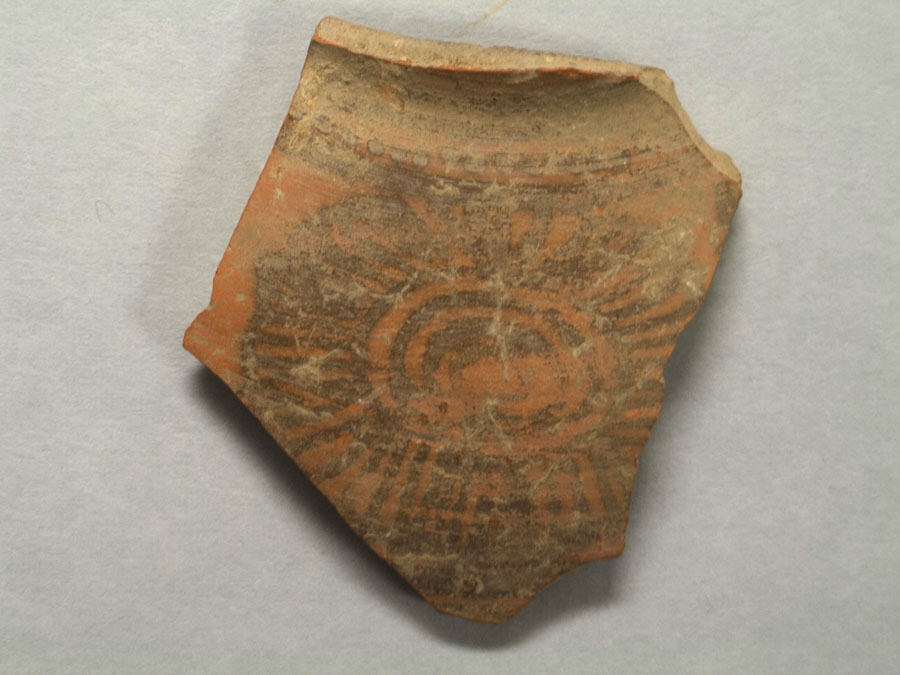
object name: shard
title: Shard: Flower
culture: pakistani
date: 301-500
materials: terracotta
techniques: painting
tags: gandhara,flowers